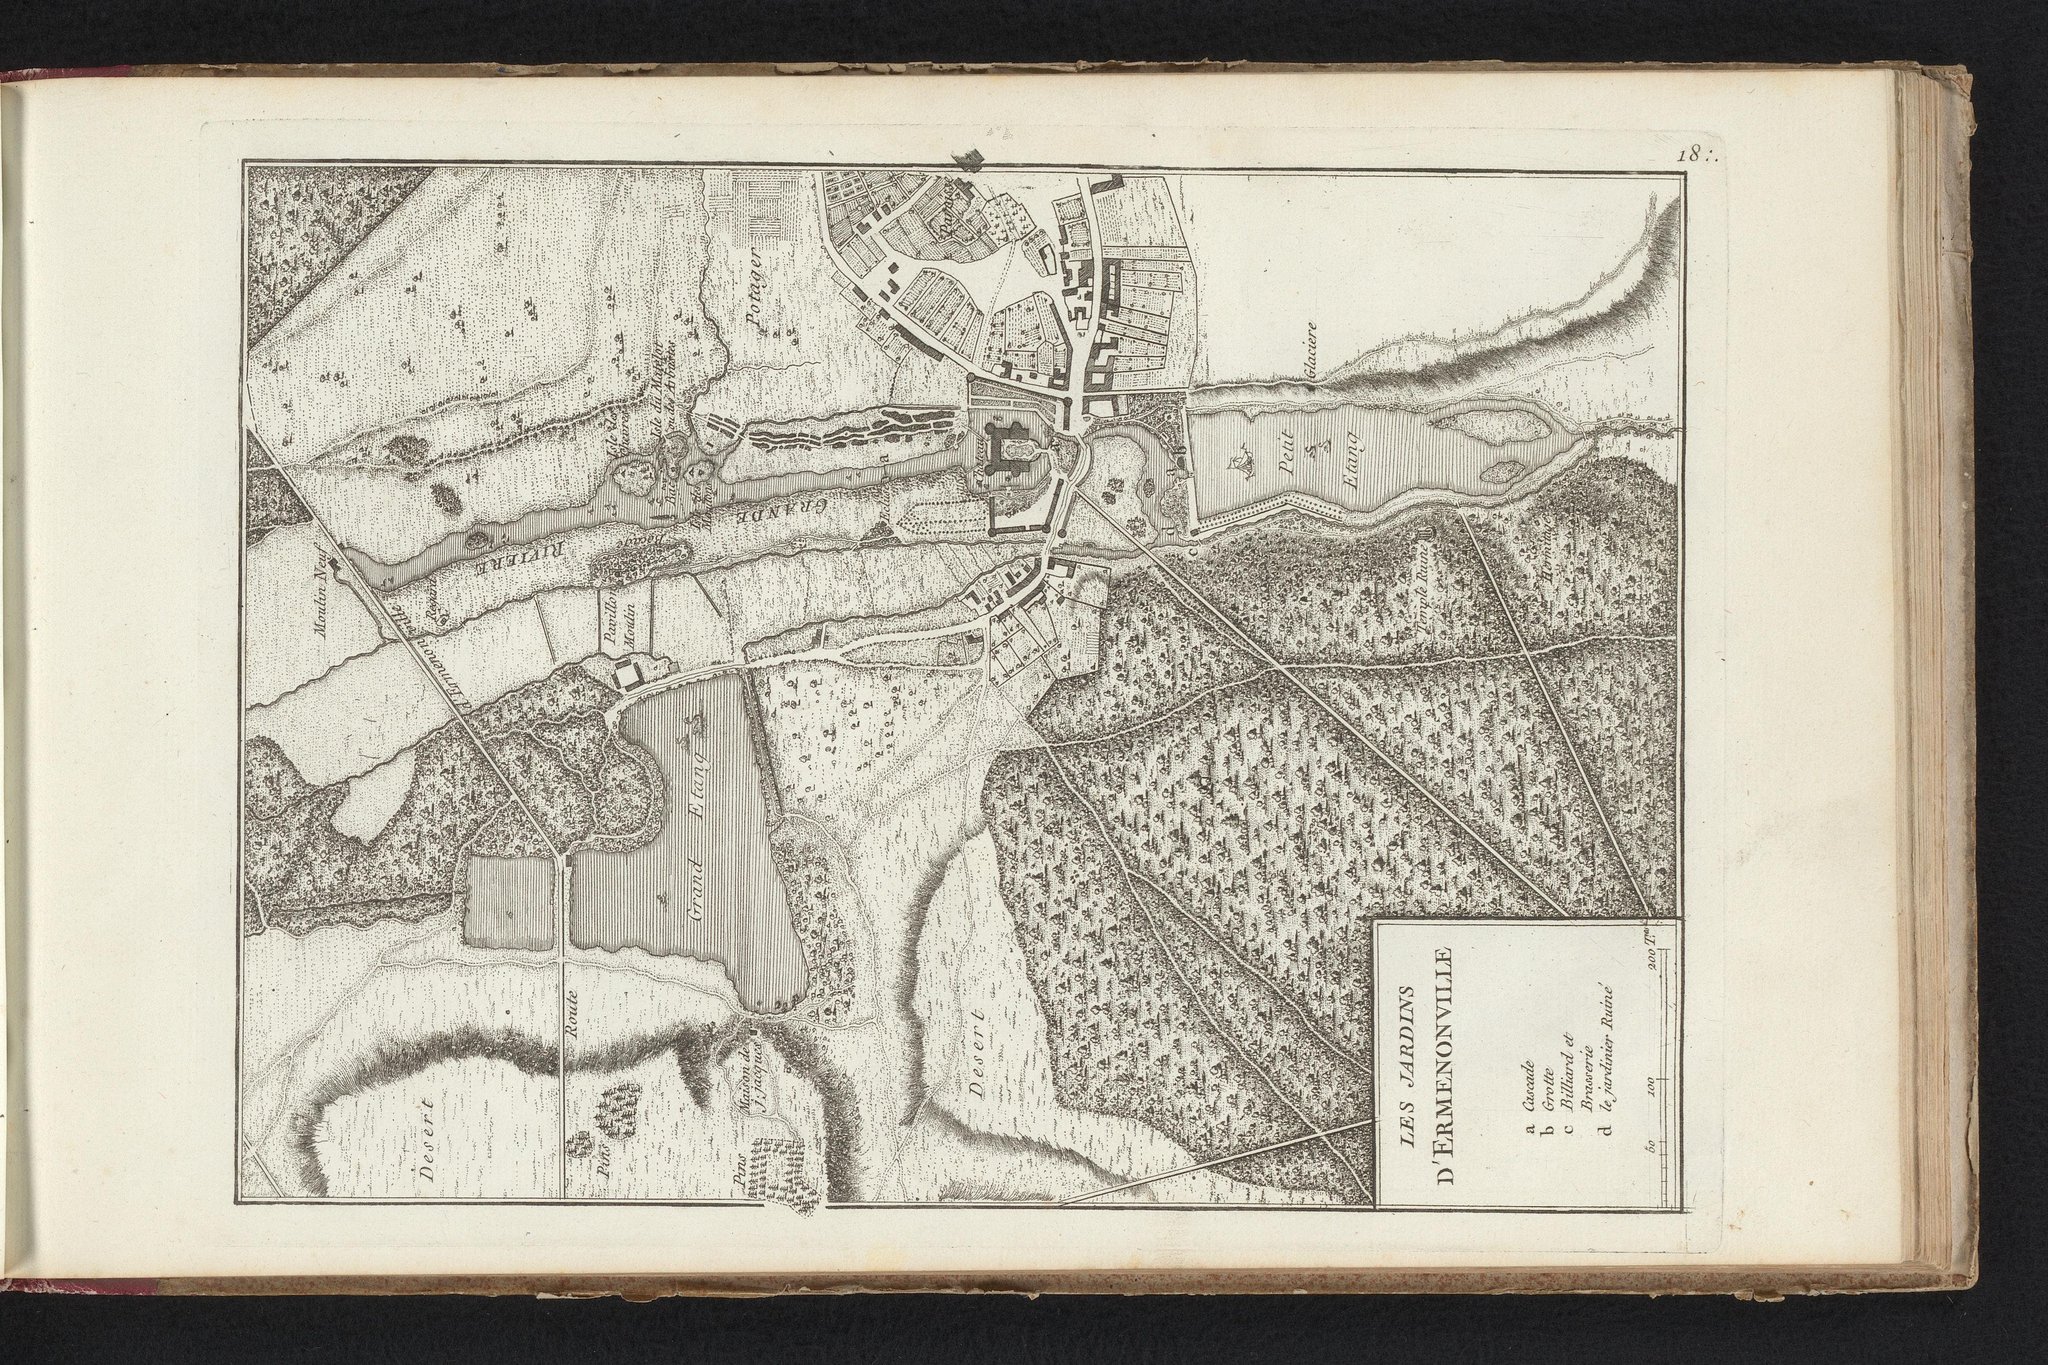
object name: album leaf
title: Les jardins d'Ermenonville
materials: paper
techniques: engraving, etching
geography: paris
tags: plan, map of garden, castle, garden buildings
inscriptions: collector's mark: Lugt 2760, collector's mark: Lugt 2228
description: De serie 'Jardins anglo-chinois à la mode' verscheen in totaal in 21 zogeheten 'cahiers' (afleveringen). De huidige prent komt uit het derde 'cahier'. Het Rijksmuseum Amsterdam bezit drie banden met daarin in totaal zes 'cahiers' van deze reeks. In de documentatie wordt verwezen naar een in de bibliotheek van het Rijksmuseum Amsterdam aanwezige facsimile van het complete werk.